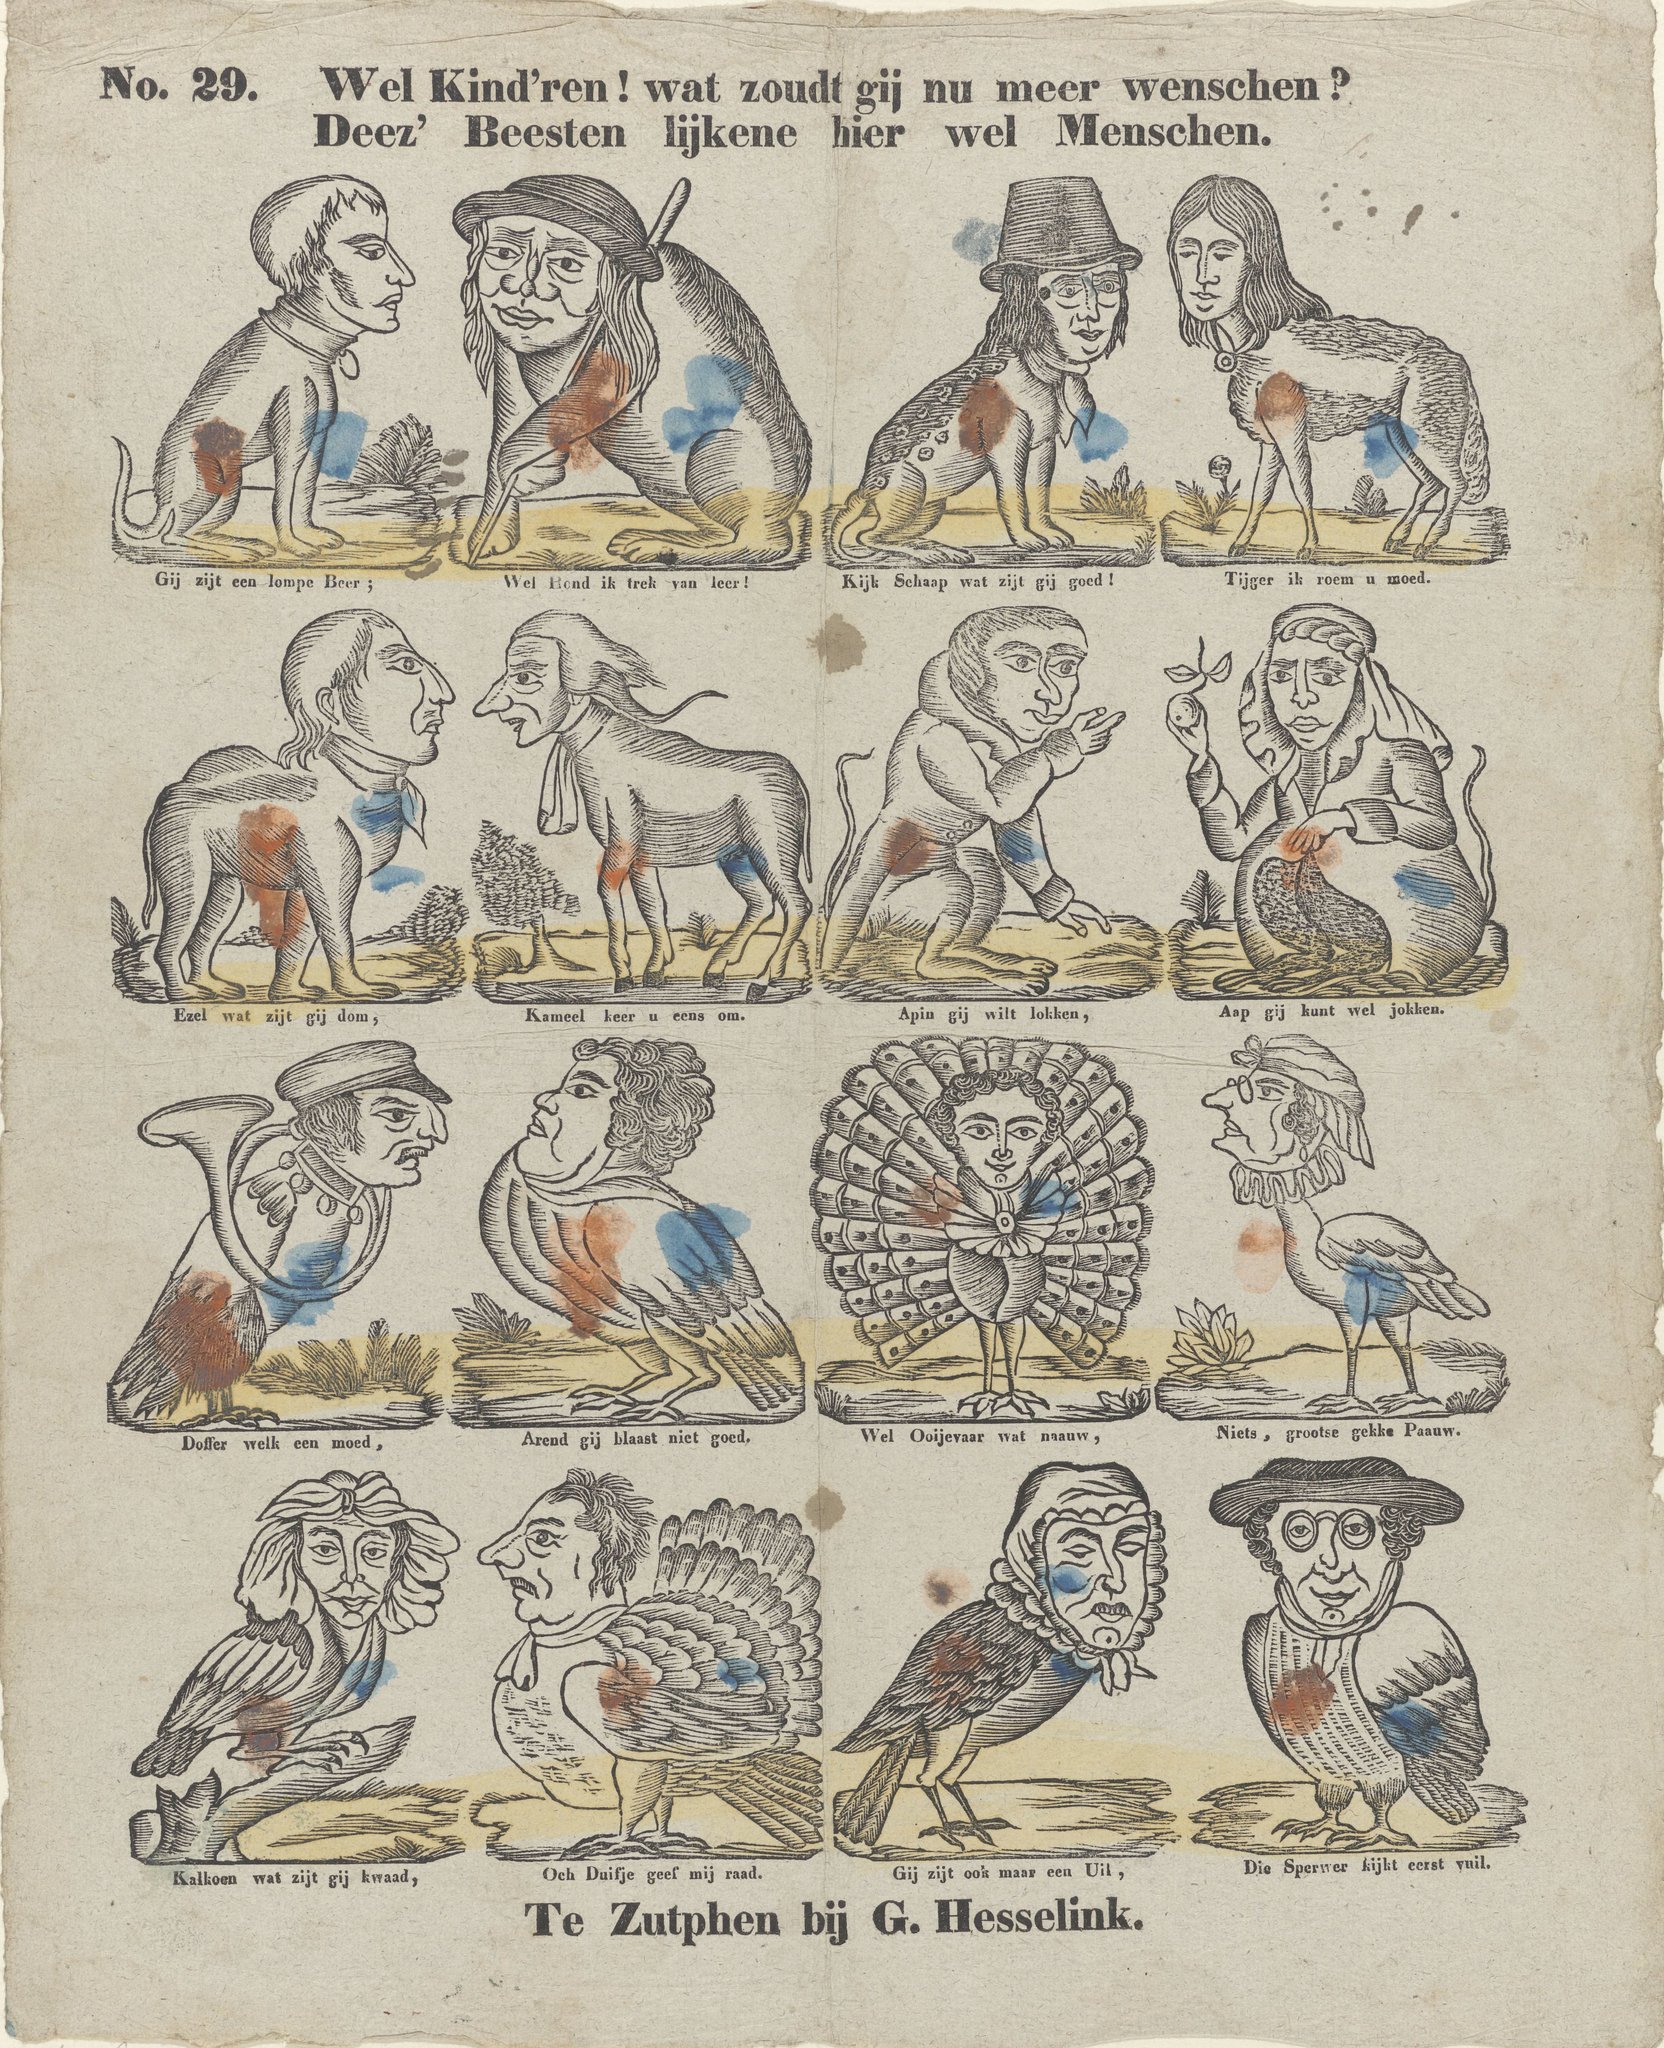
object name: popular print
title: Wel kinderen! wat zoudt gij nu meer wenschen? / Deez' beesten lijkenen hier wel menschen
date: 1816-1849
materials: paper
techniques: colour, letterpress printing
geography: zutphen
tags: animals with human head - aa - female human figure, animals with human head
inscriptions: collector's mark: Lugt 2760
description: Blad met 16 voorstellingen van dierenlijven met een mensenhoofd, waaronder de lijven van een hond, een aap en een pauw. Onder elke voorstelling een onderschrift. Genummerd linksboven: no. 29.